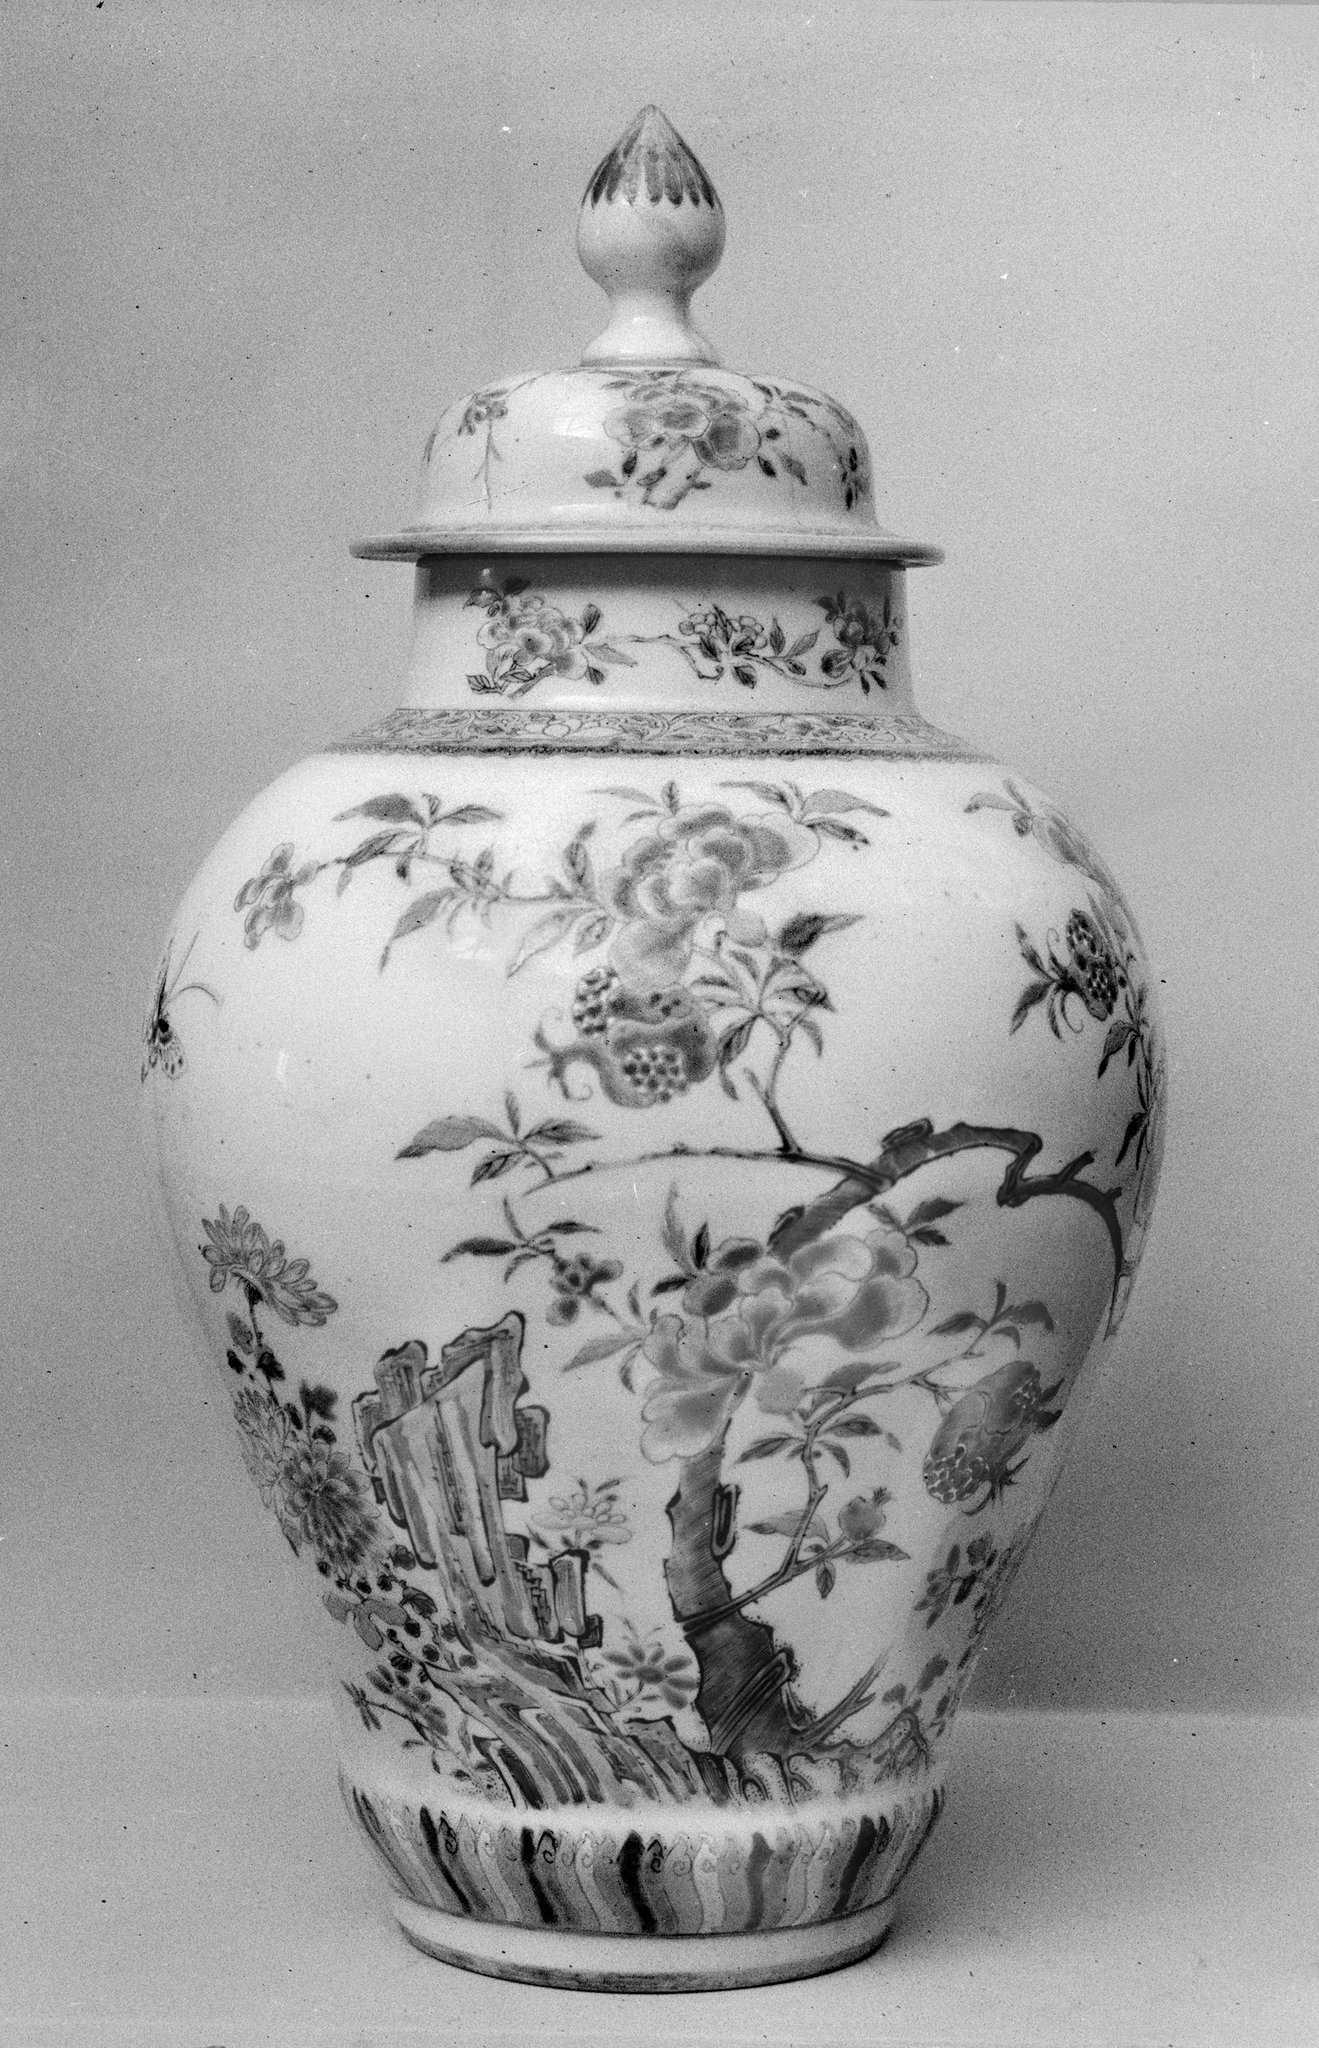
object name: jar with cover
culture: chinese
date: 1736-1795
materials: porcelain